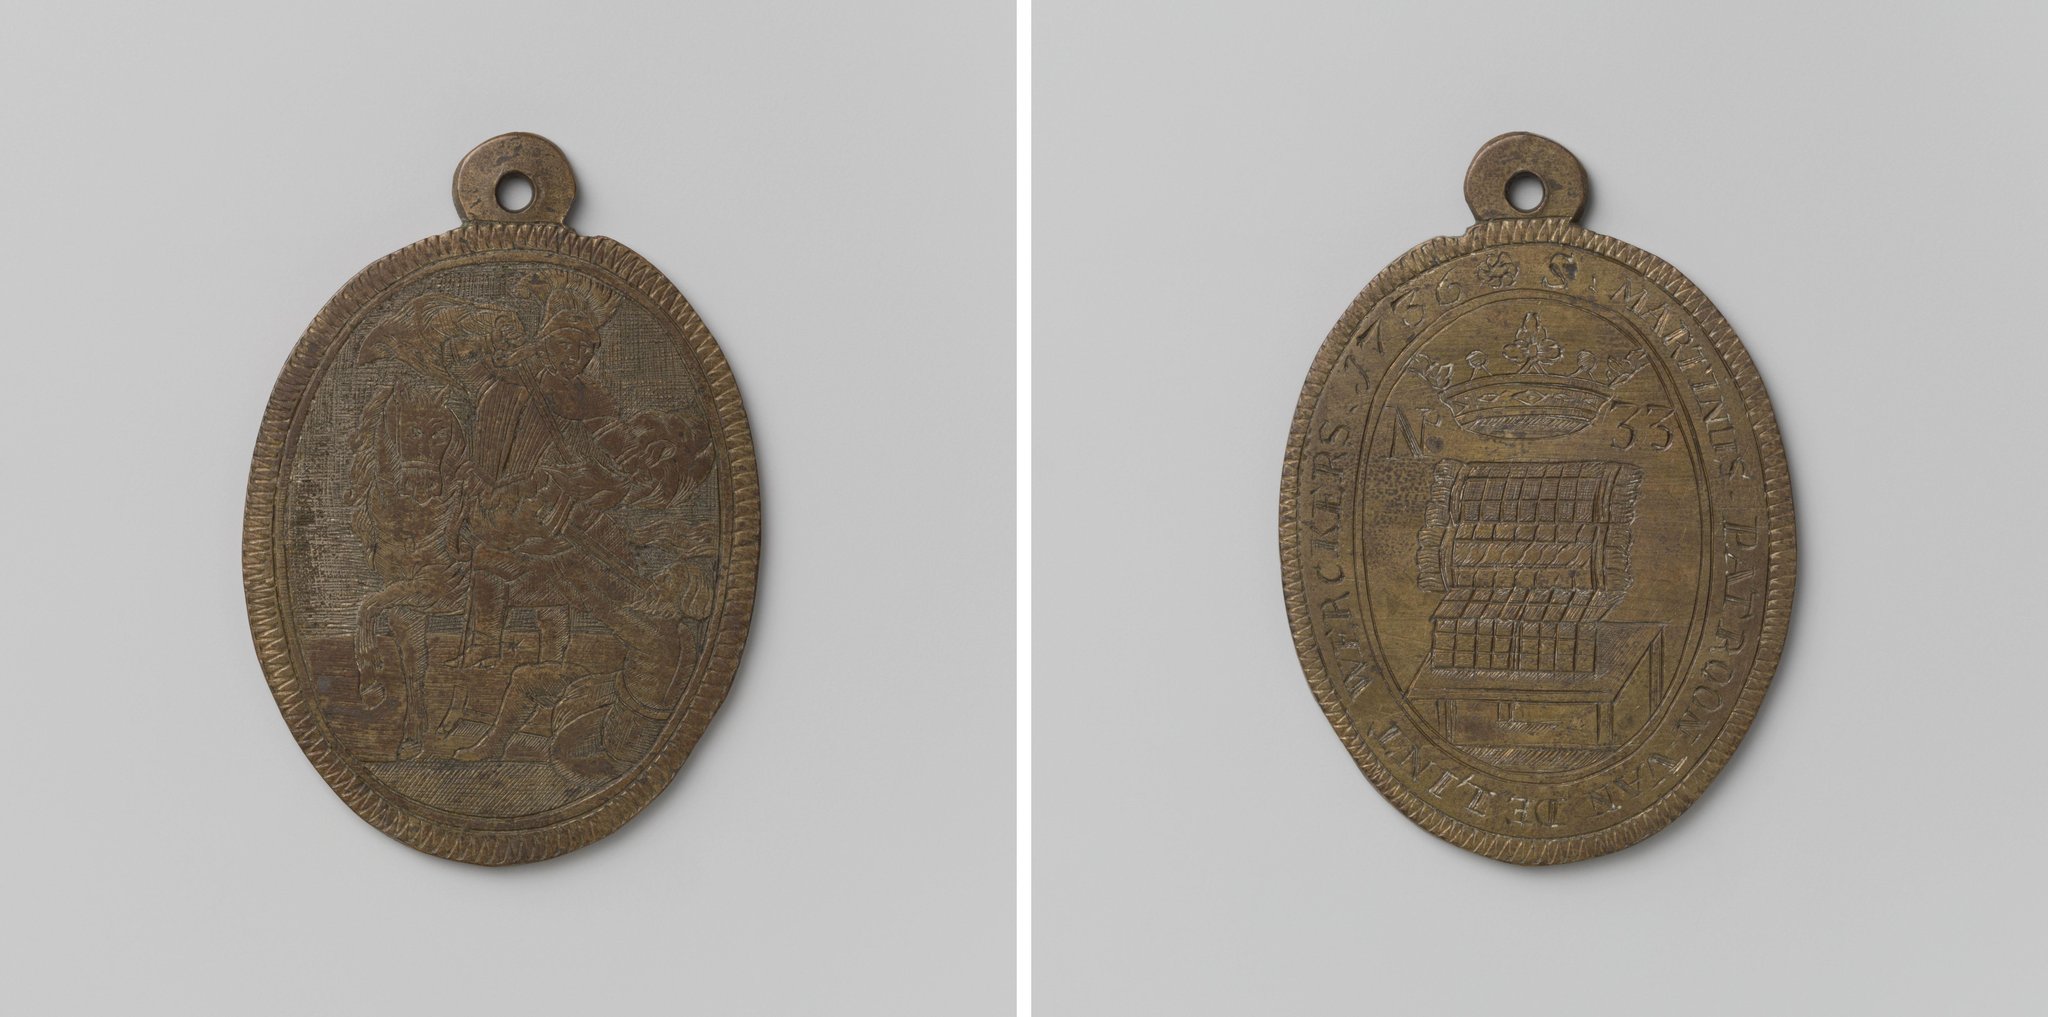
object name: medal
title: Lintwerkersgilde van 's-Hertogenbosch, gildepenning met no. 33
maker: Anonymous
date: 1736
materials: brass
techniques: engraving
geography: den bosch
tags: den bosch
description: Ovale messing penning aan draagoog. Voorzijde: gehelmde St. Maarten te paard snijdt zijn mantel doormidden; voor hem op grond zit half geklede man, wiens stok op grond ligt, met uitgestrekte armen binnen gearceerde rand. Keerzijde: een aantal op elkaar geplaatste rollen lint op een tafel onder kroon tussen opschrift No. 33 binnen omschrift.